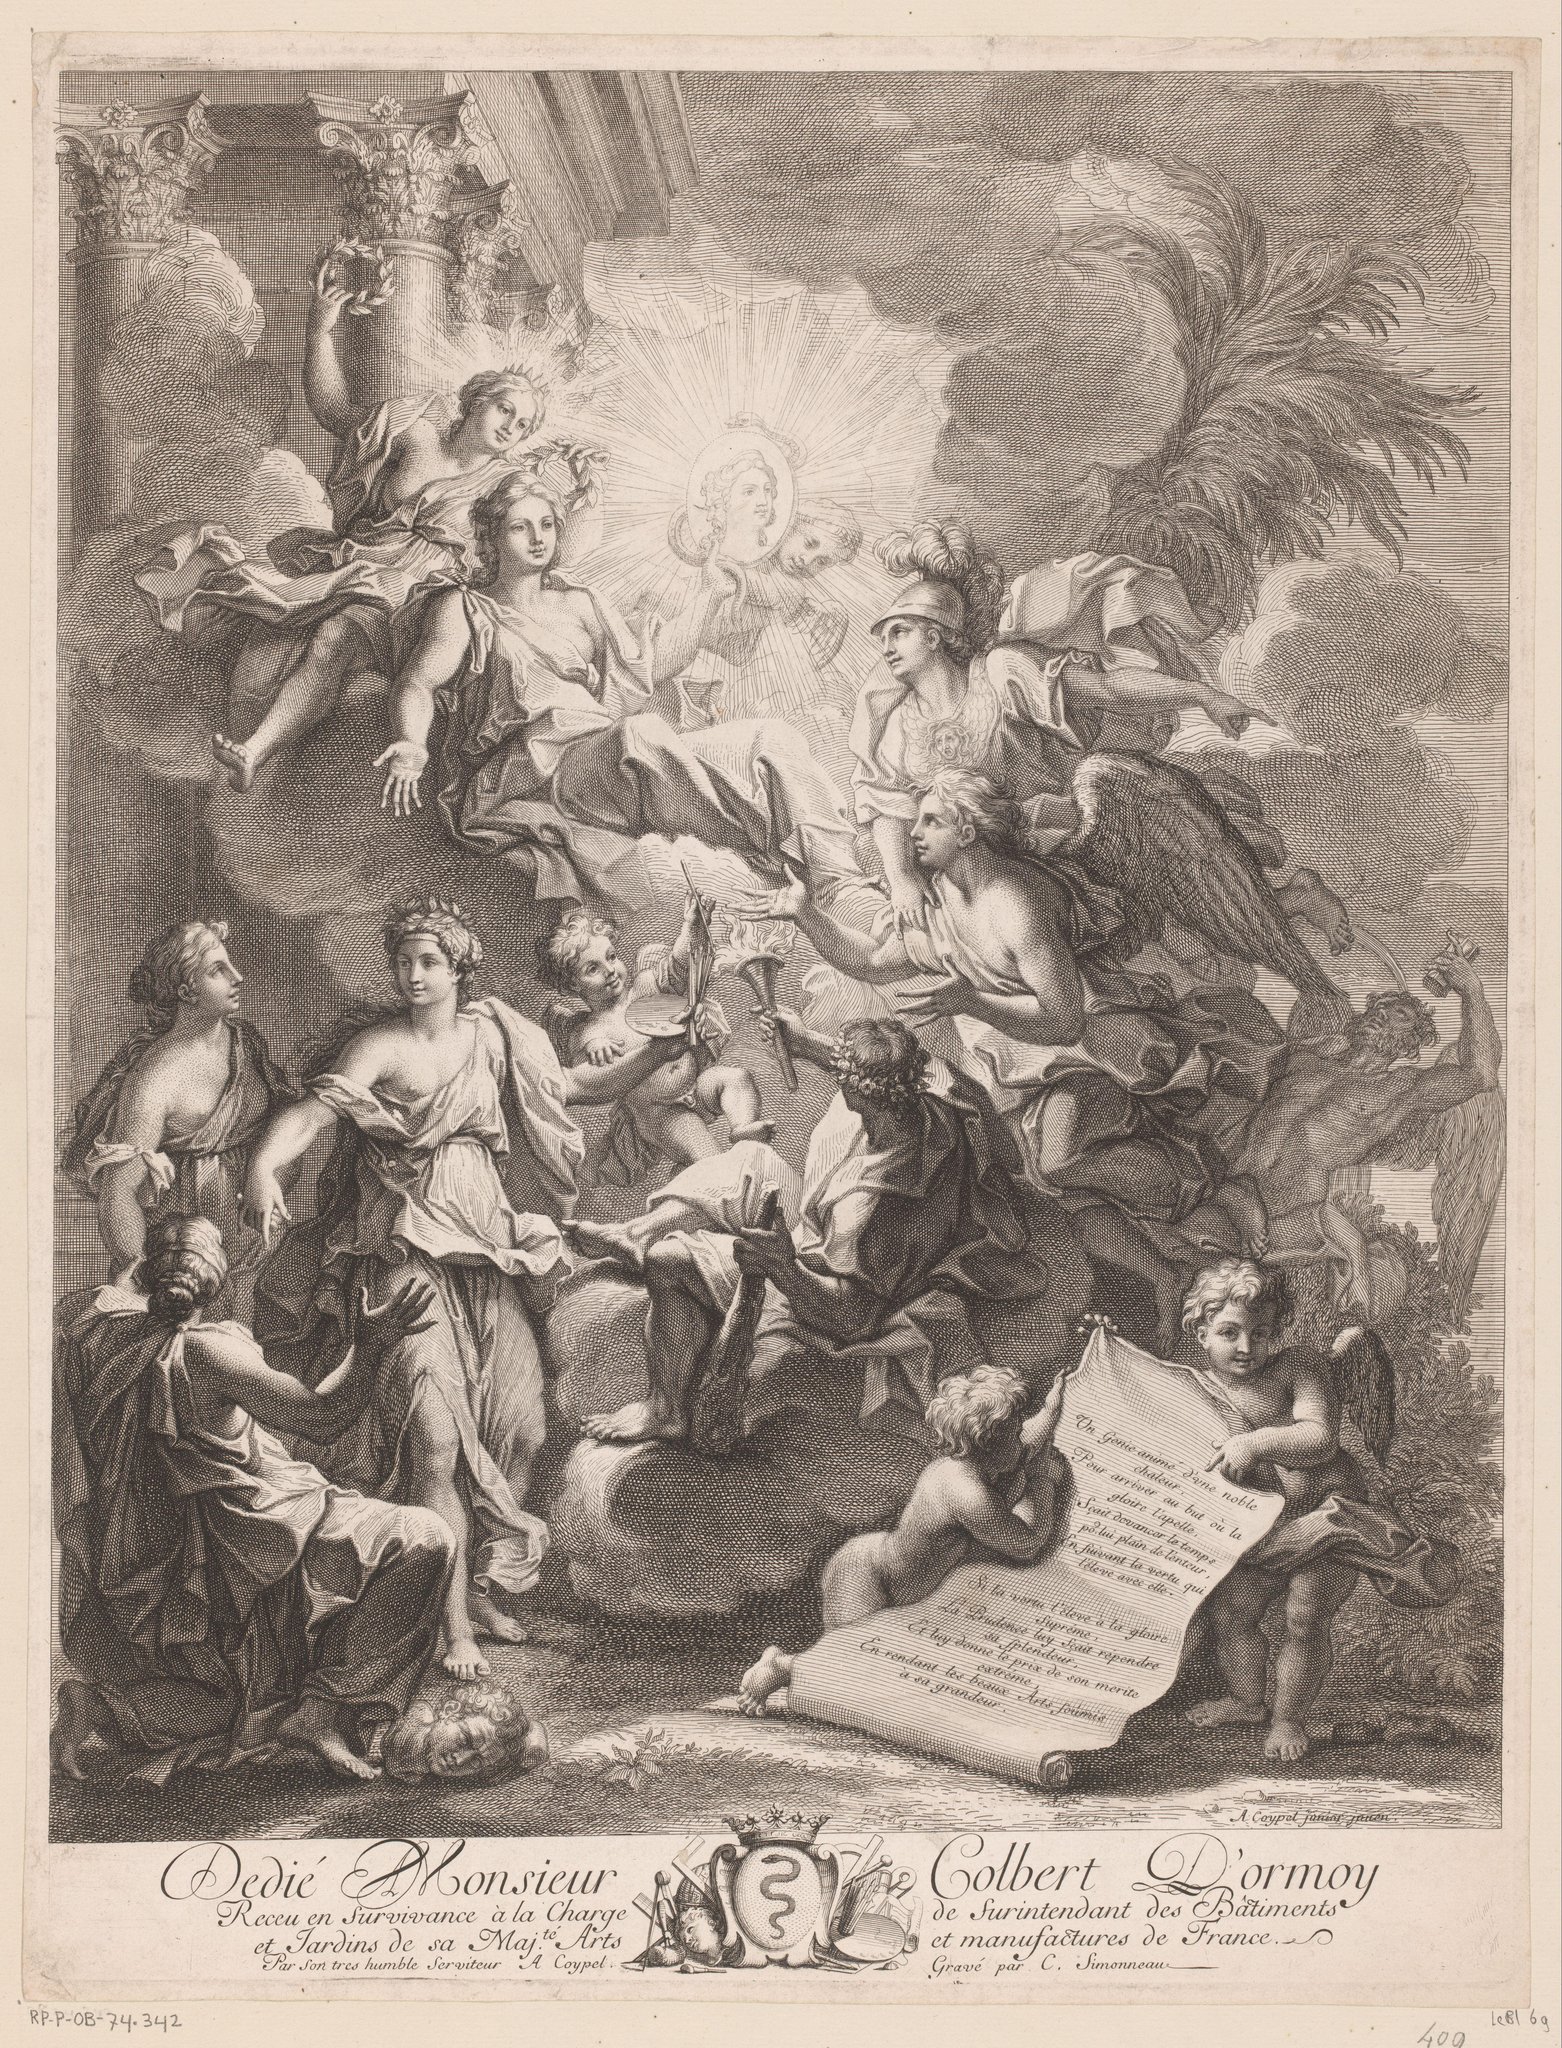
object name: print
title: Allegorie op Jean-Baptiste Michel Colbert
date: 1655-1728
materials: paper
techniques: engraving, etching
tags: paris, france, jean-baptiste michel colbert, (story of) minerva (pallas, athena), symbolic representations, allegories and emblems ~ the graphic arts, father time, man with wings and scythe, honour, glory; 'ampiezza della gloria', 'gloria', 'gloria de prencipi', 'gloria & honore', 'honore', 'sublimatà della gloria' (ripa)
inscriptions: collector's mark: Lugt 240